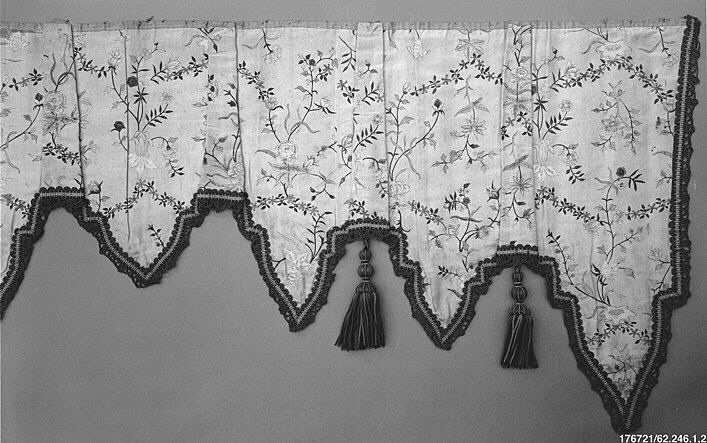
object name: valance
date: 1701-1800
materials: cotton, paint, silk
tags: flowers